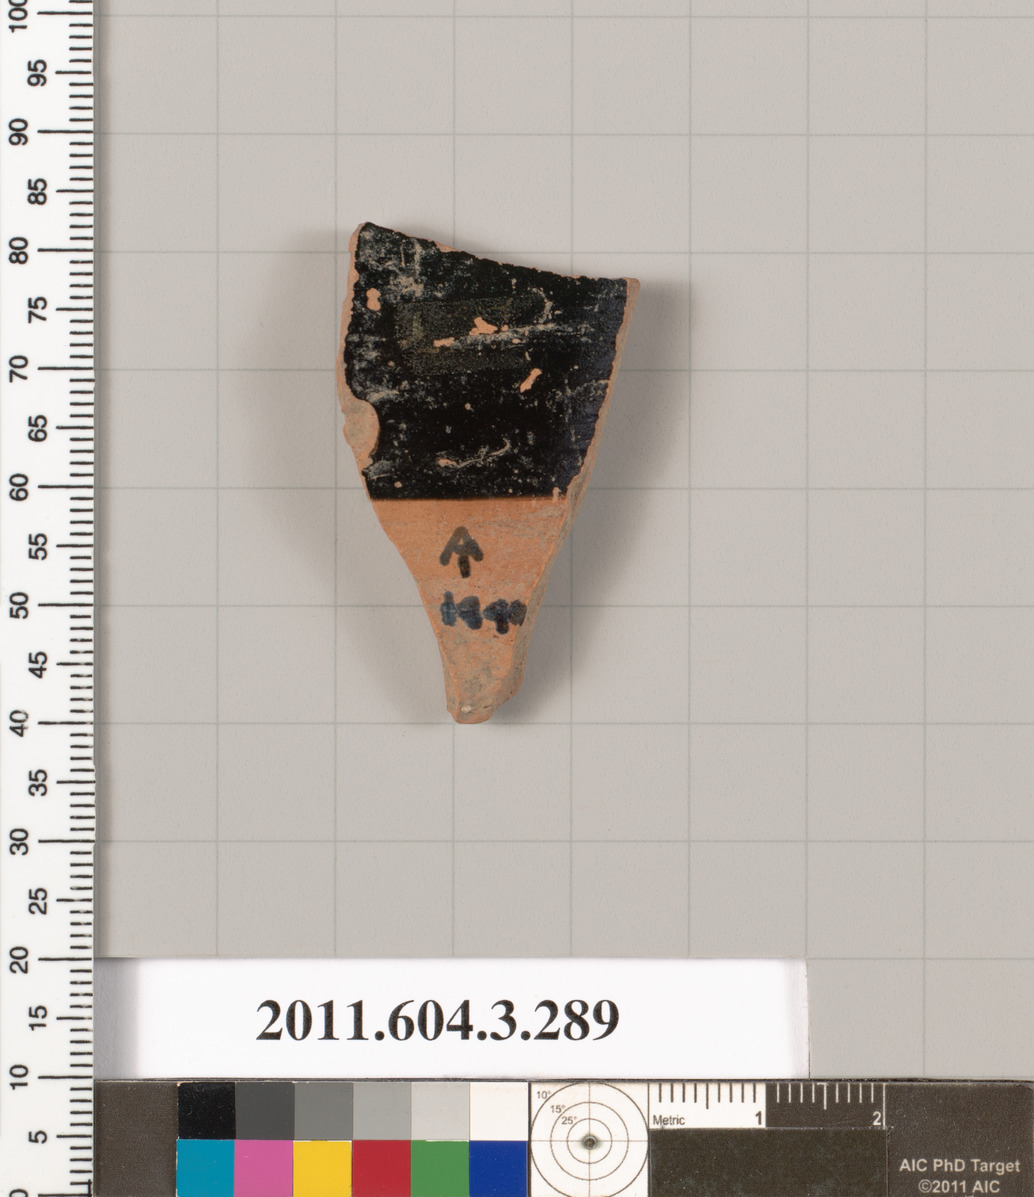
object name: neck amphora fragment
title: Terracotta fragment of a neck-amphora (jar)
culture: greek, attic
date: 525-501 BCE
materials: terracotta